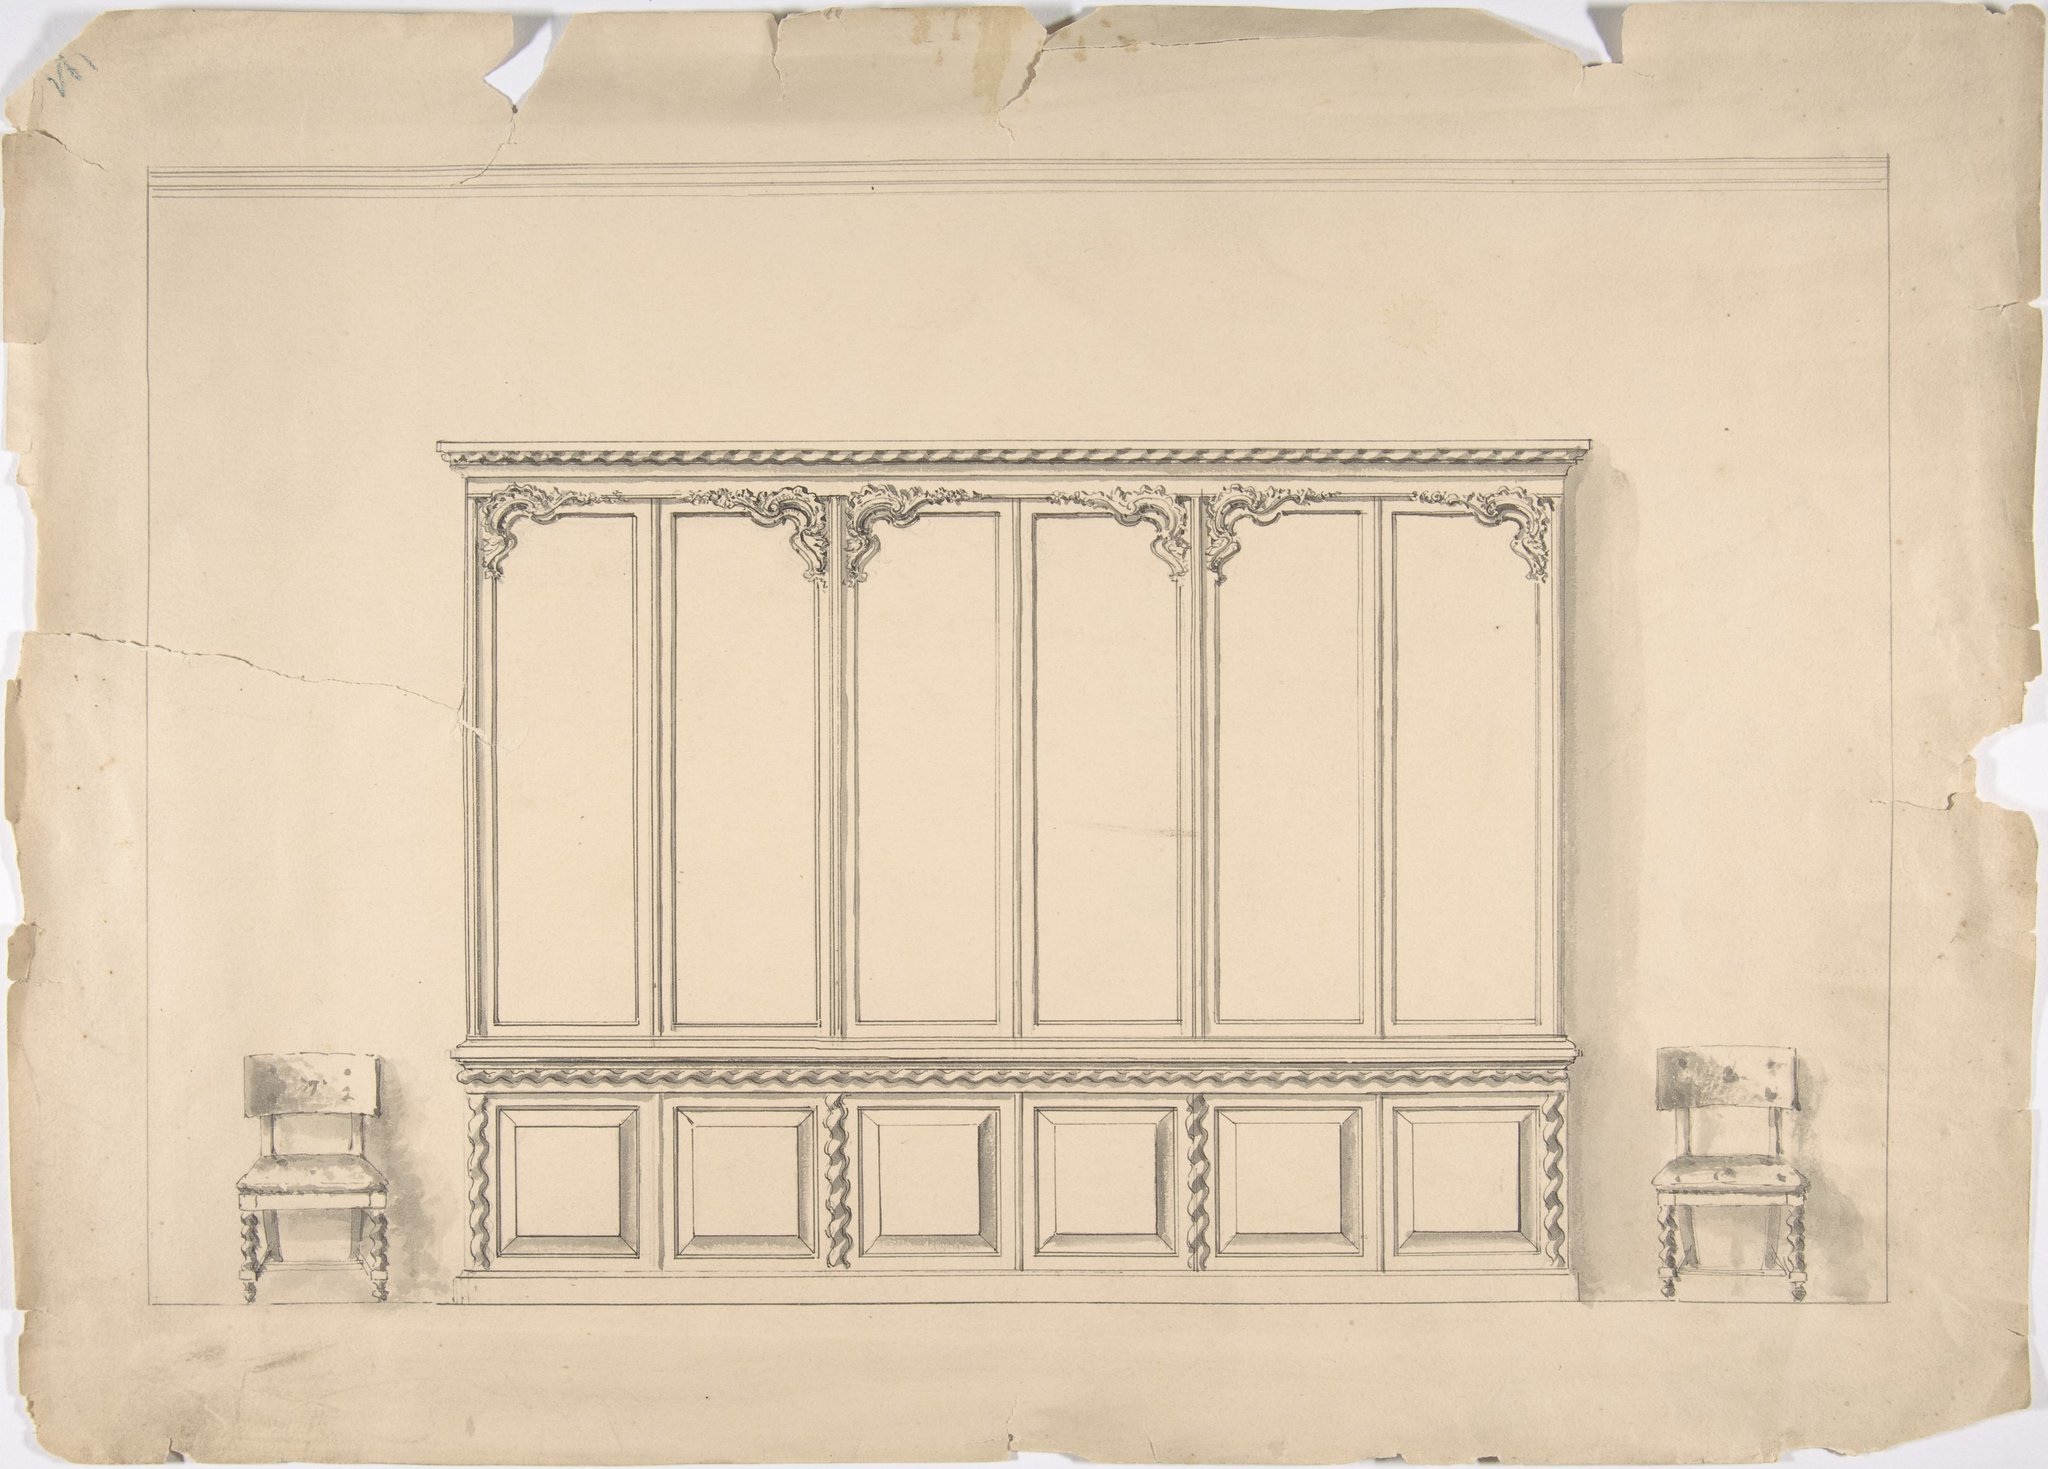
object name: drawing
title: Design for a Very Large Cabinet with Turned Elements, and Two Chairs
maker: anonymous, british, 19th century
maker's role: artist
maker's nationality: british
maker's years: 1800-1900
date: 1801-1833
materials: ink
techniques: brush, pen, wash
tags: chairs,cabinets